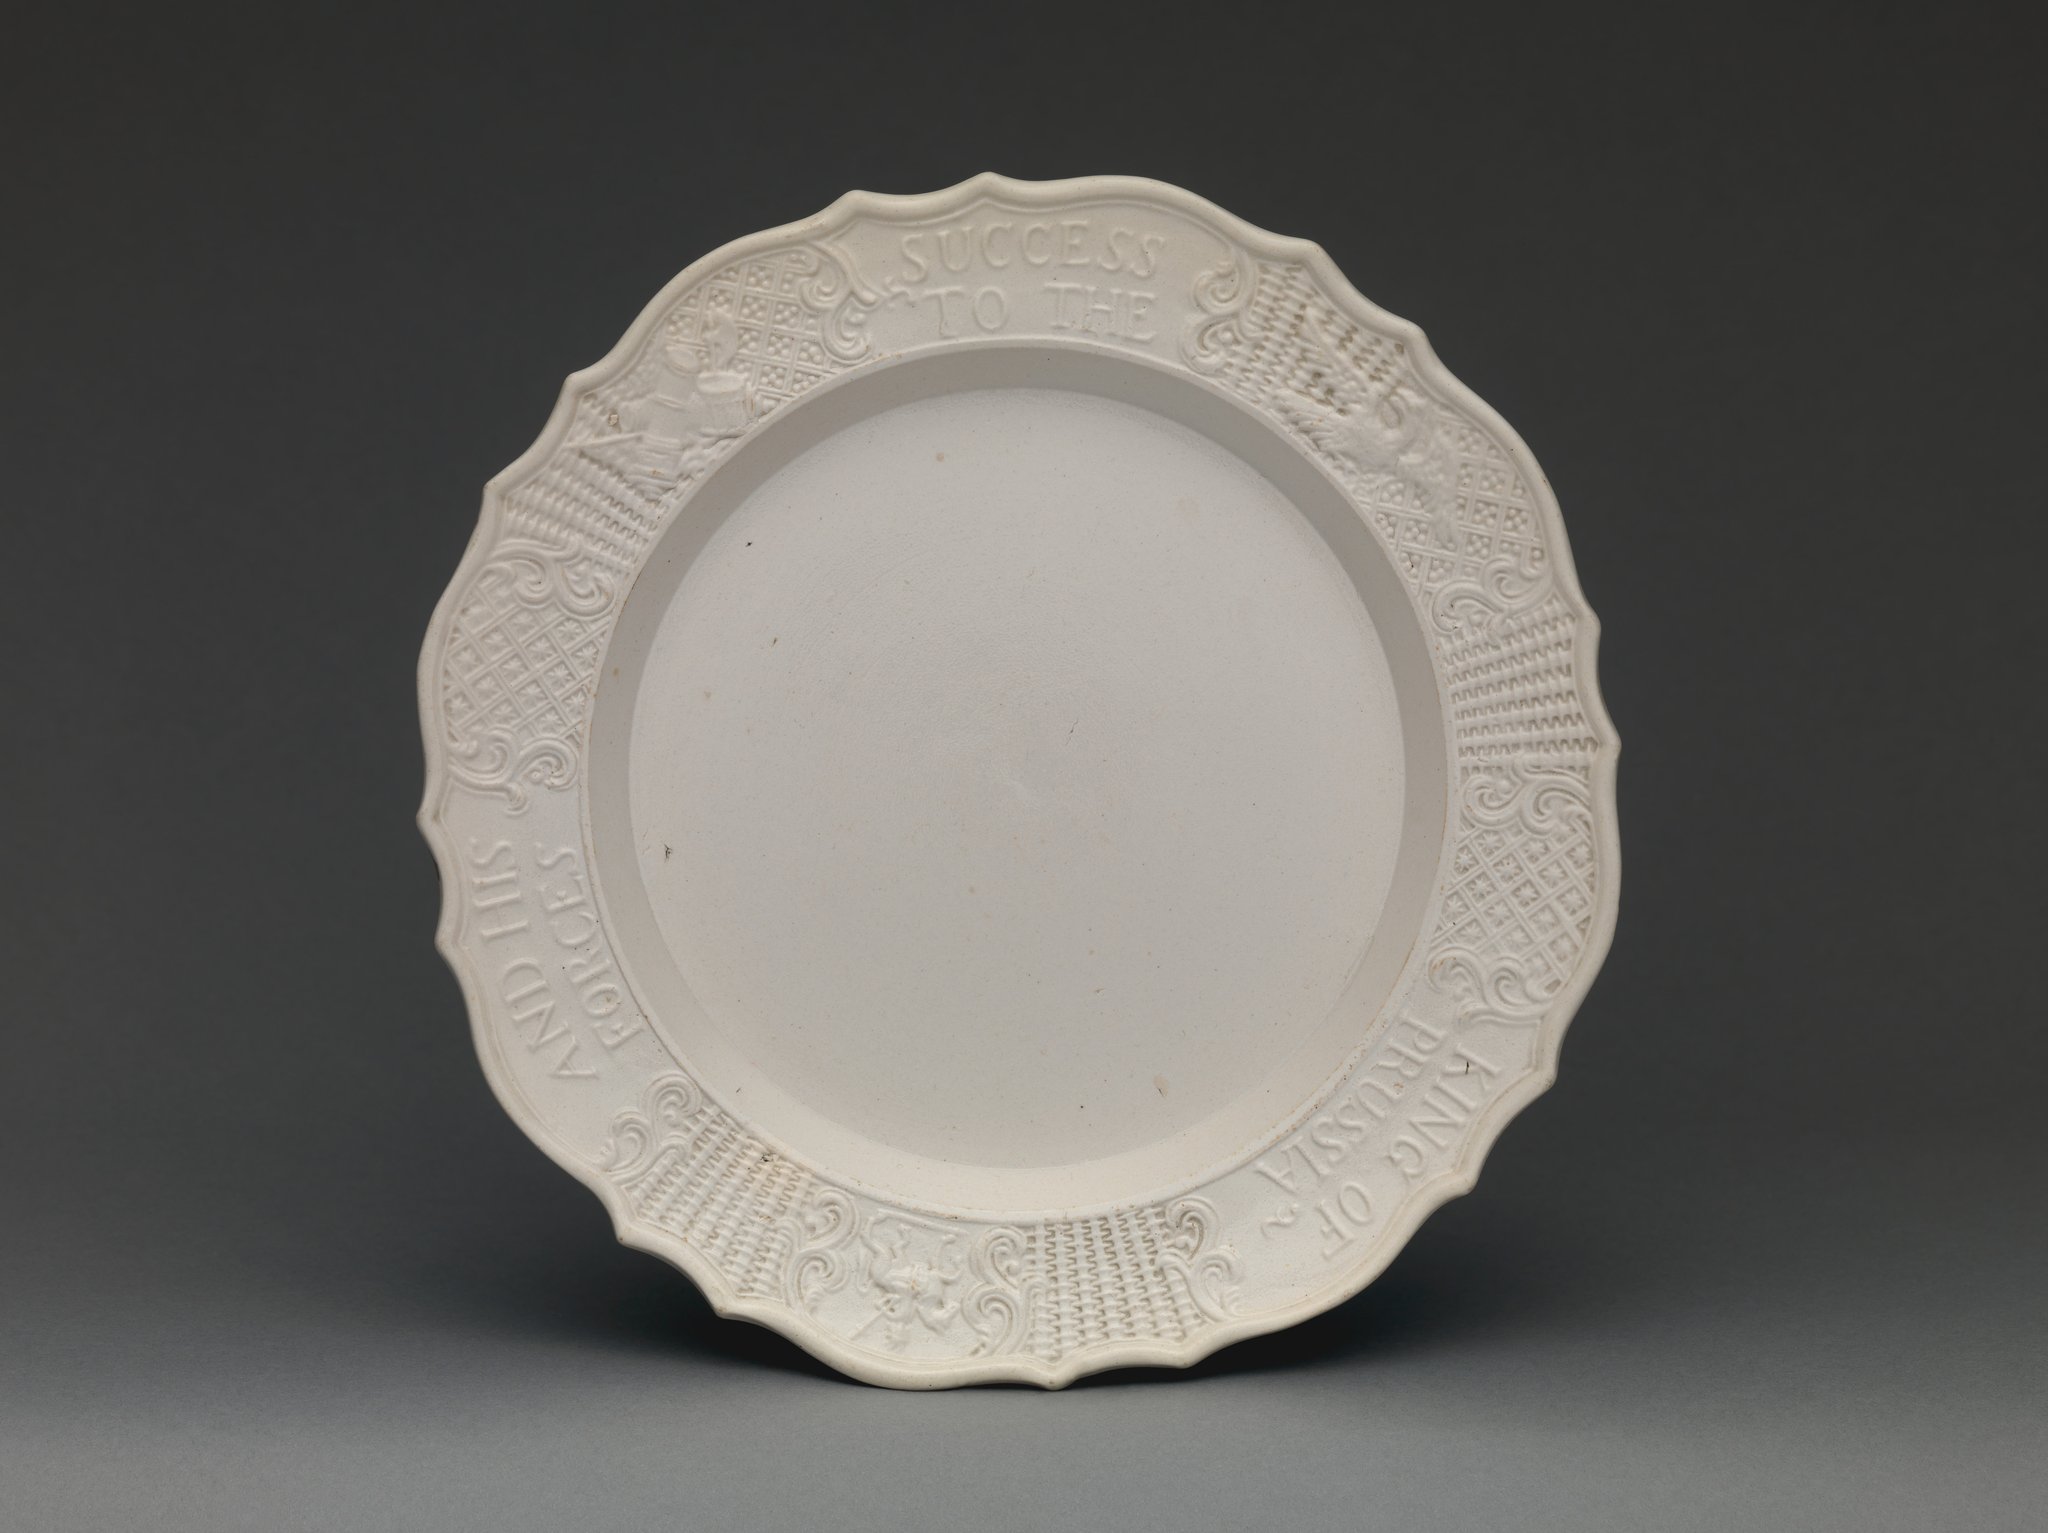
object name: dish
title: Dish with King of Prussia inscription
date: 1756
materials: stoneware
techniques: salt glaze